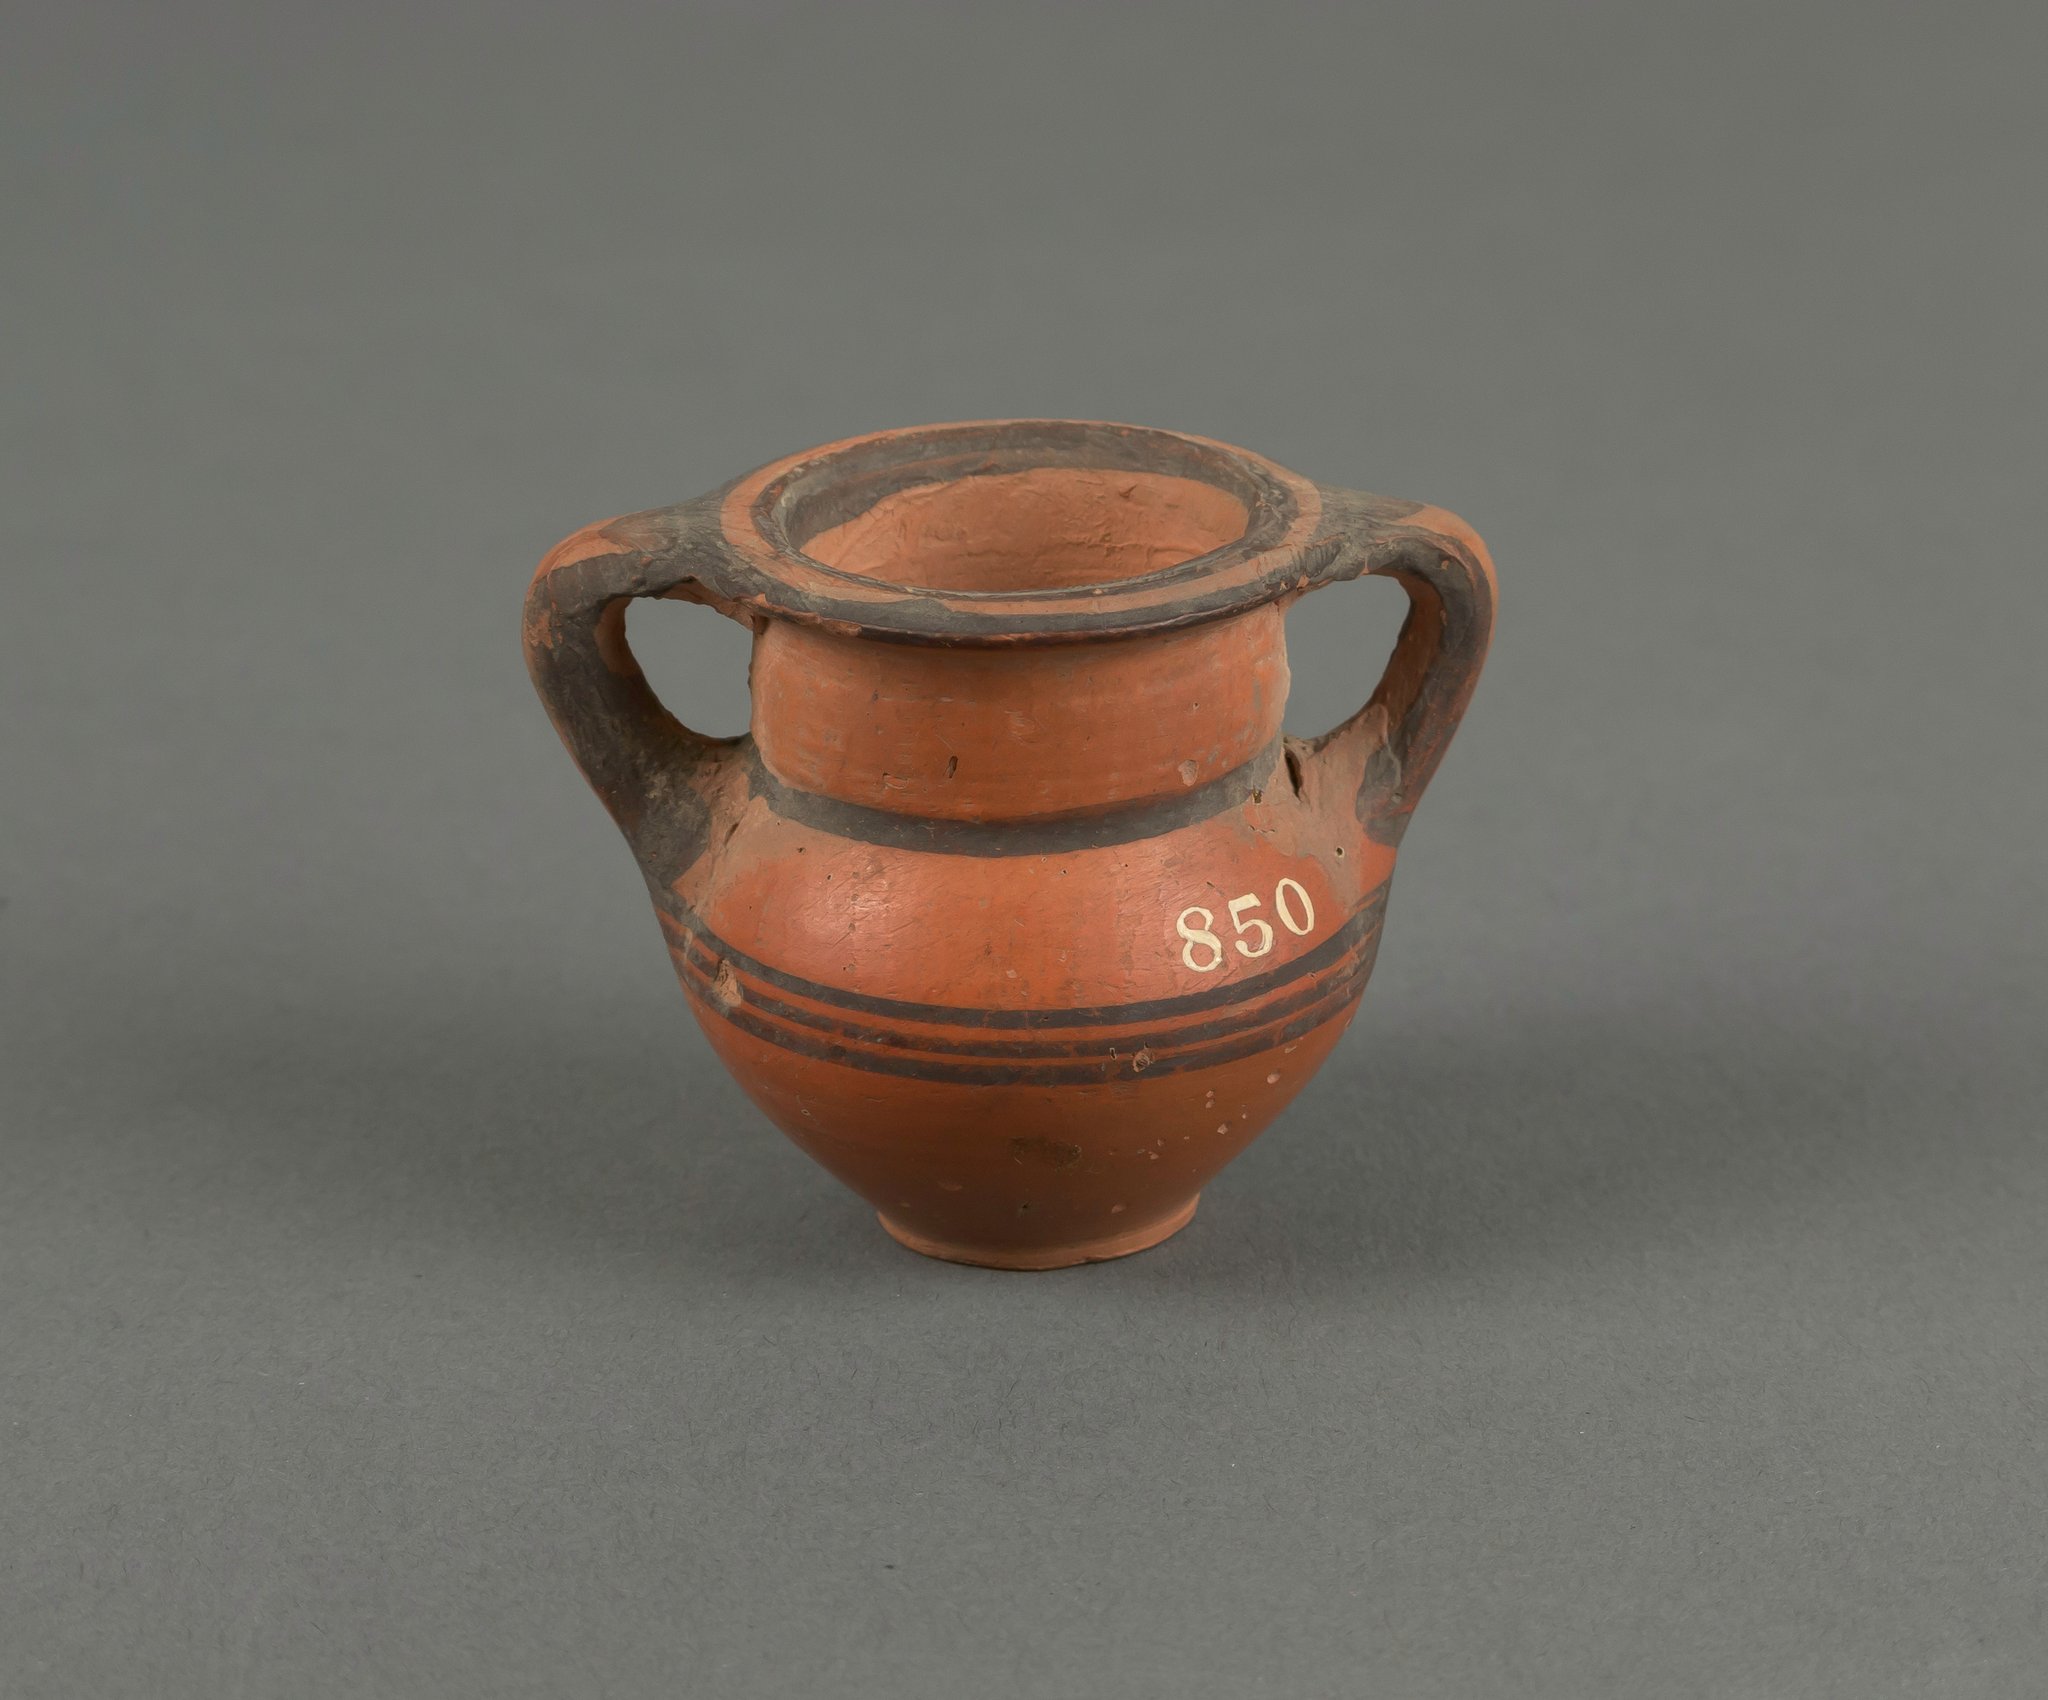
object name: amphora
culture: cypriot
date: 750-600 BCE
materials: terracotta